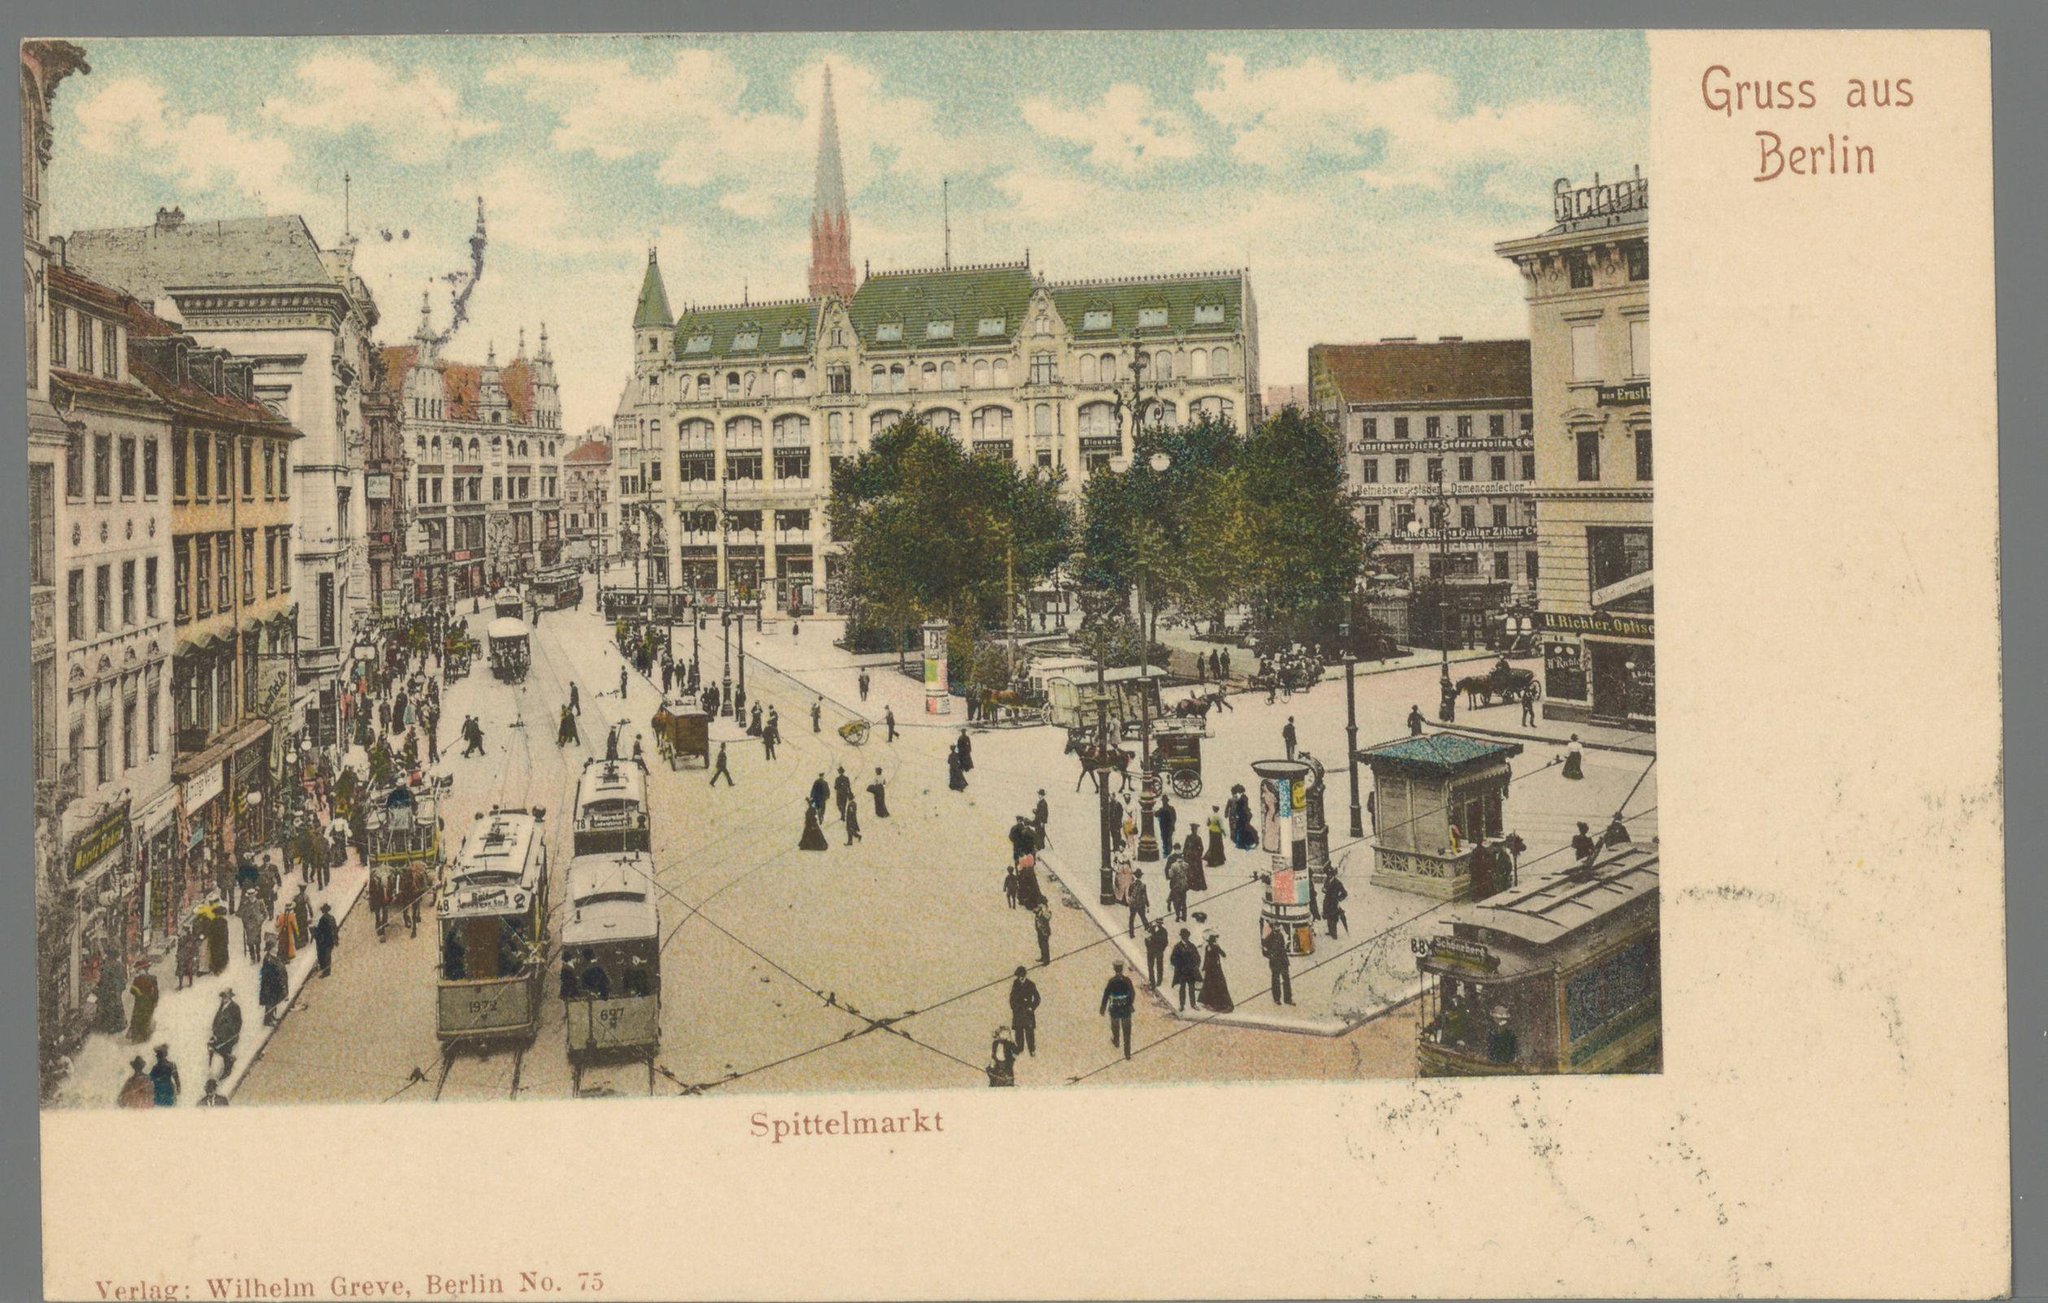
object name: ansichtkaart, prentbriefkaart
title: Gruss aus Berlin. Spittelmarkt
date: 1890-1903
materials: cardboard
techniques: photograph, lithograph, writing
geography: berlin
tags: square, place, circus, etc.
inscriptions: postage stamp